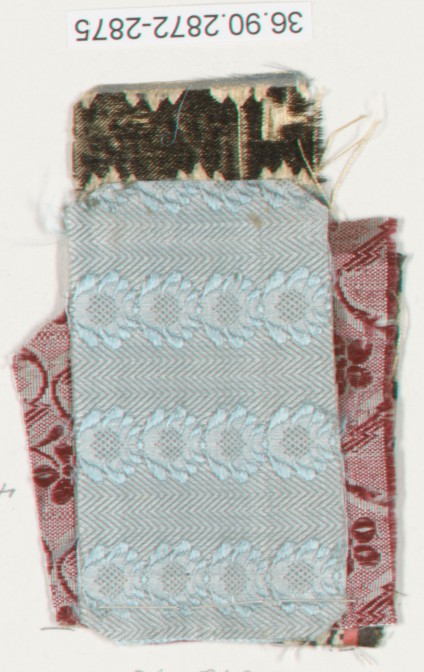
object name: piece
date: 1801-1900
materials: silk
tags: flowers